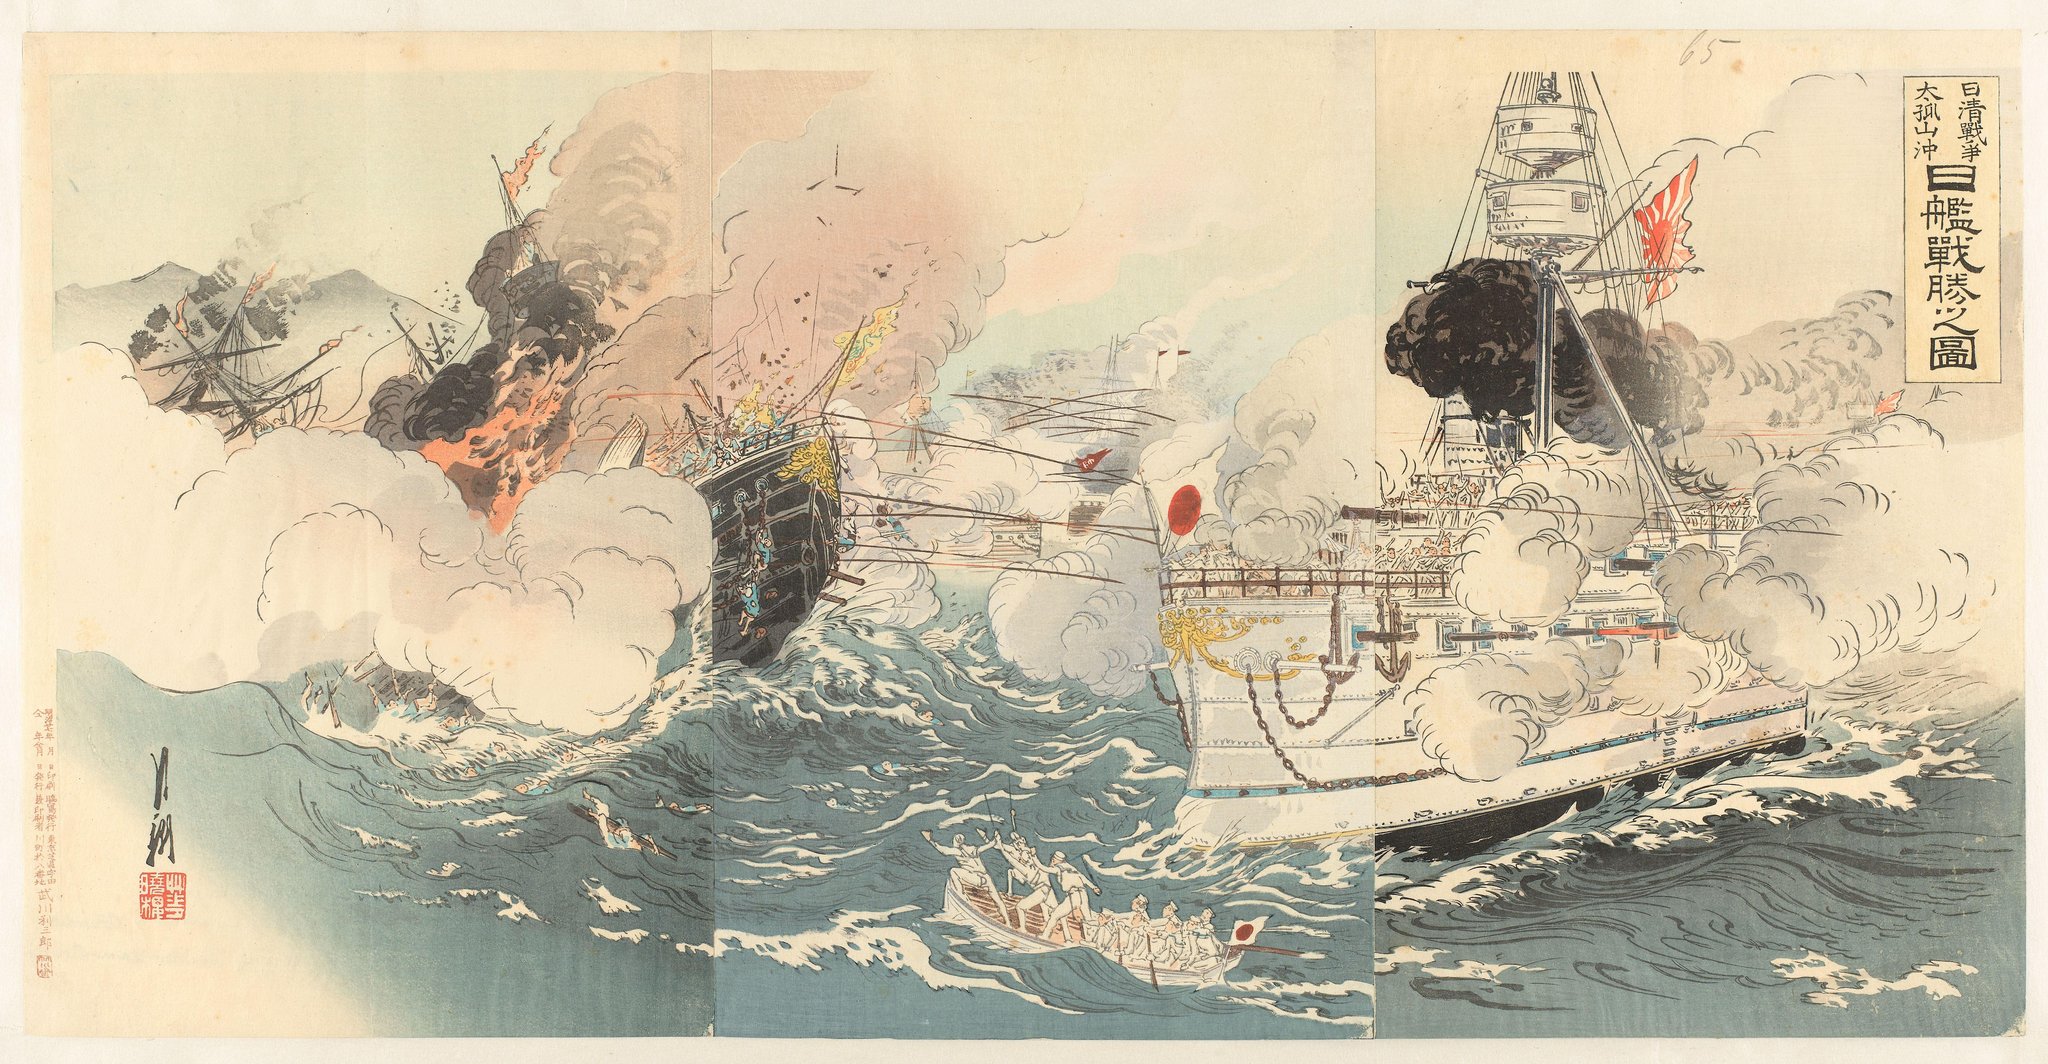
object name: triptych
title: Nisshin sensô Daikosan oki Shinkan gekichin no zu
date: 1894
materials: paper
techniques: woodcut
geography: japan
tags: on fire, ablaze, sinking (movement in water), battle (+ naval force)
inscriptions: inscription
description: Op de voorgrond zinkt een Chinees schip nadat het is aangevallen door de Japanse marine. Dit incident staat bekend als de Slag bij de Gele Zee, op 17 september 1894, tijdens de Eerste Chinees-Japanse Oorlog (1894-1895).